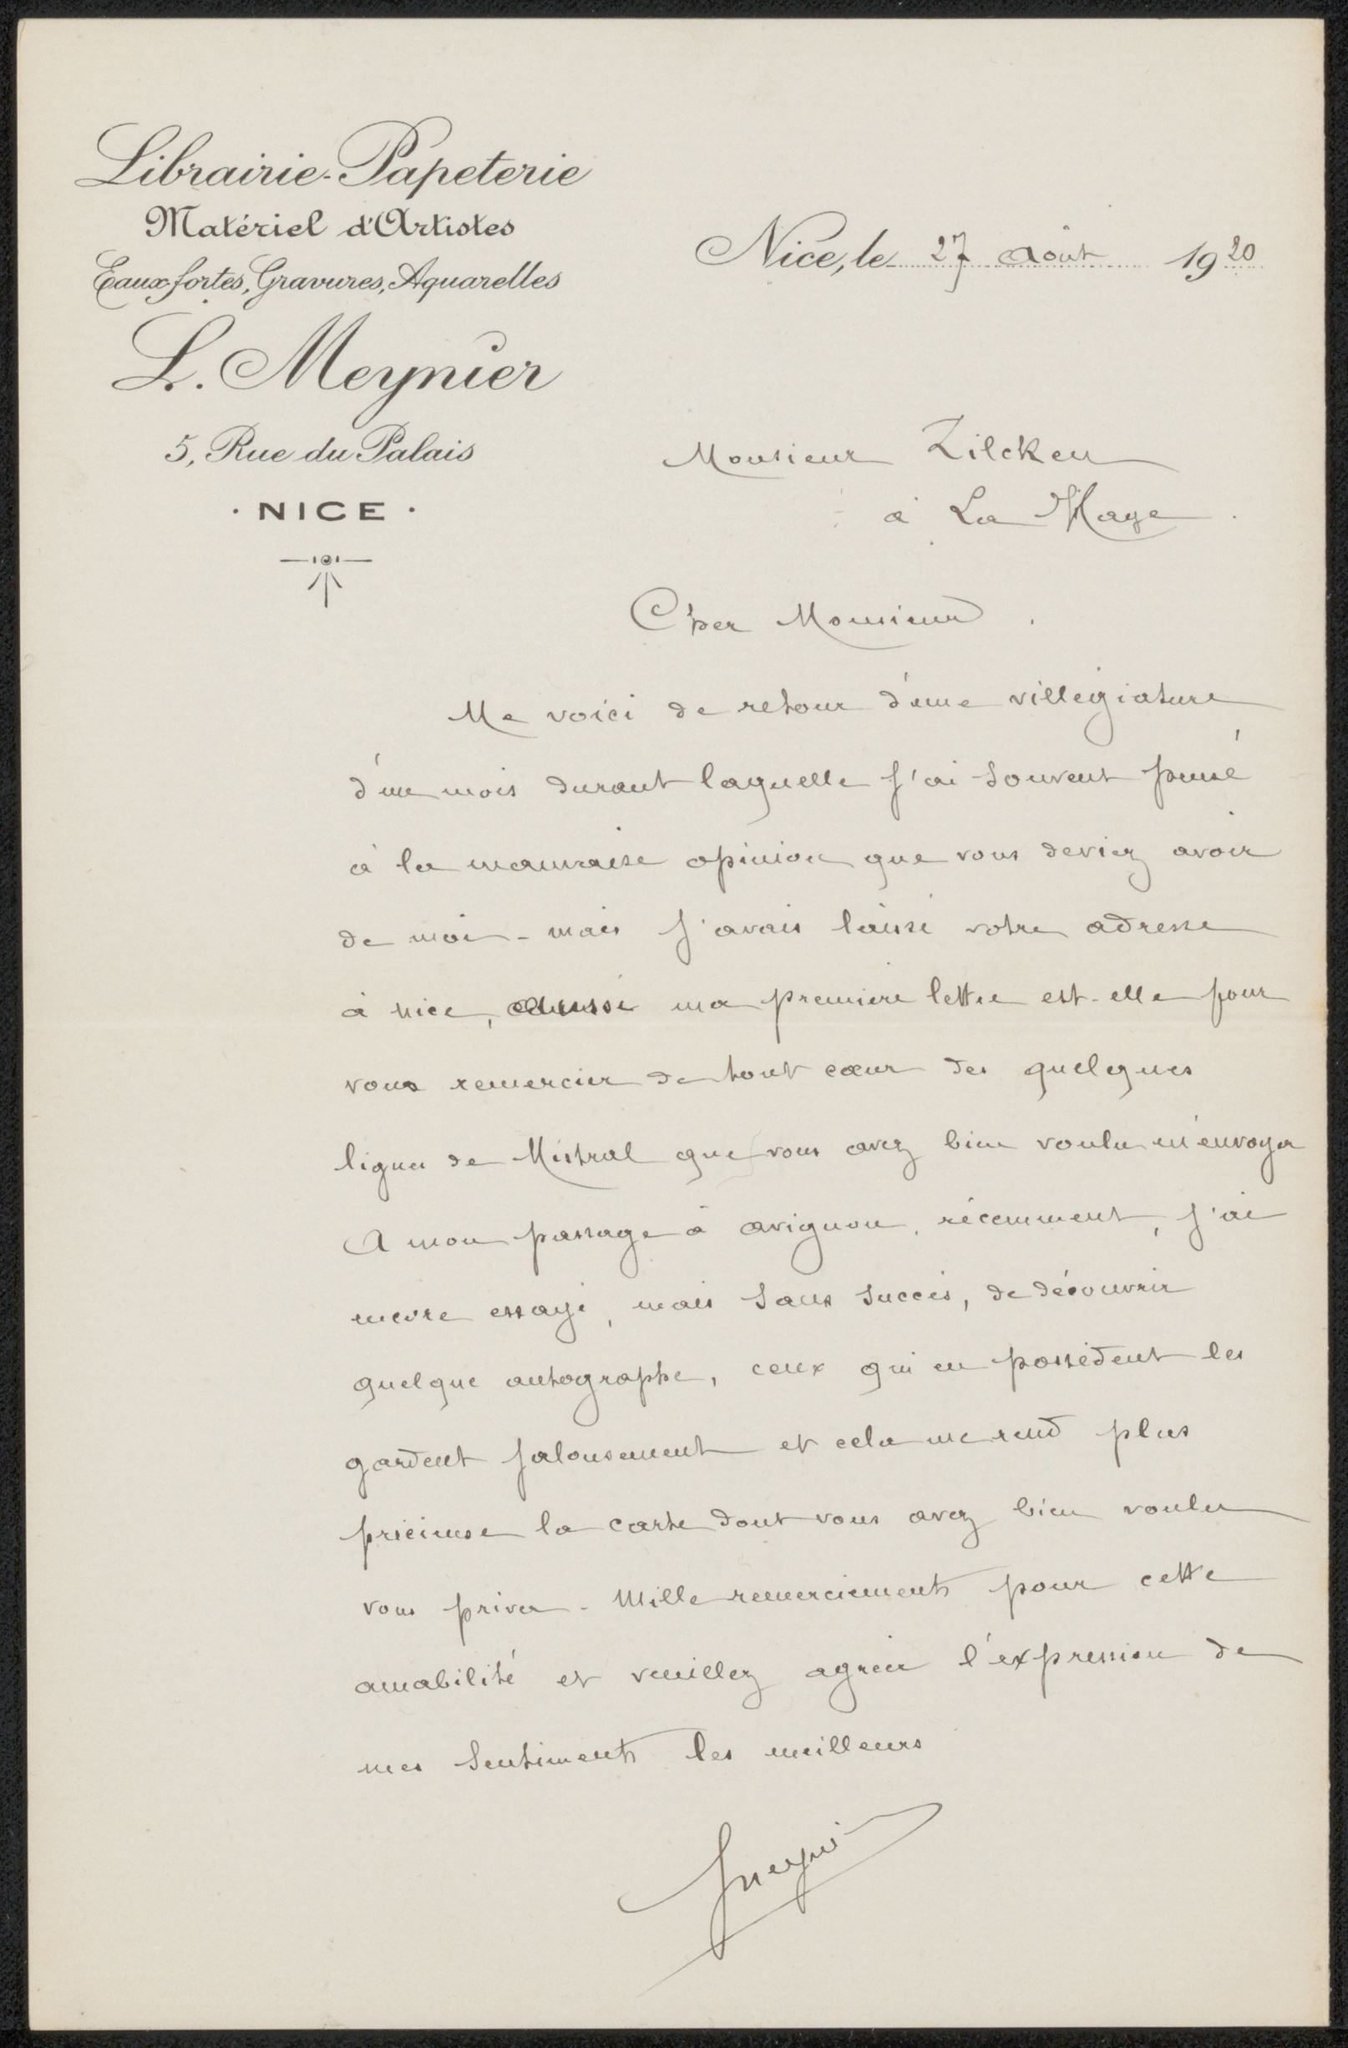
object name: letter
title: Brief aan Philip Zilcken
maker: l. meynier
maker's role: boekhandelaar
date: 1920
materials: ink, paper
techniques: pen, printing, writing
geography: nice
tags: the hague, painter, draughtsman, philip zilcken, travelling; tourism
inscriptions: collector's mark: ‘RPK’, watermark